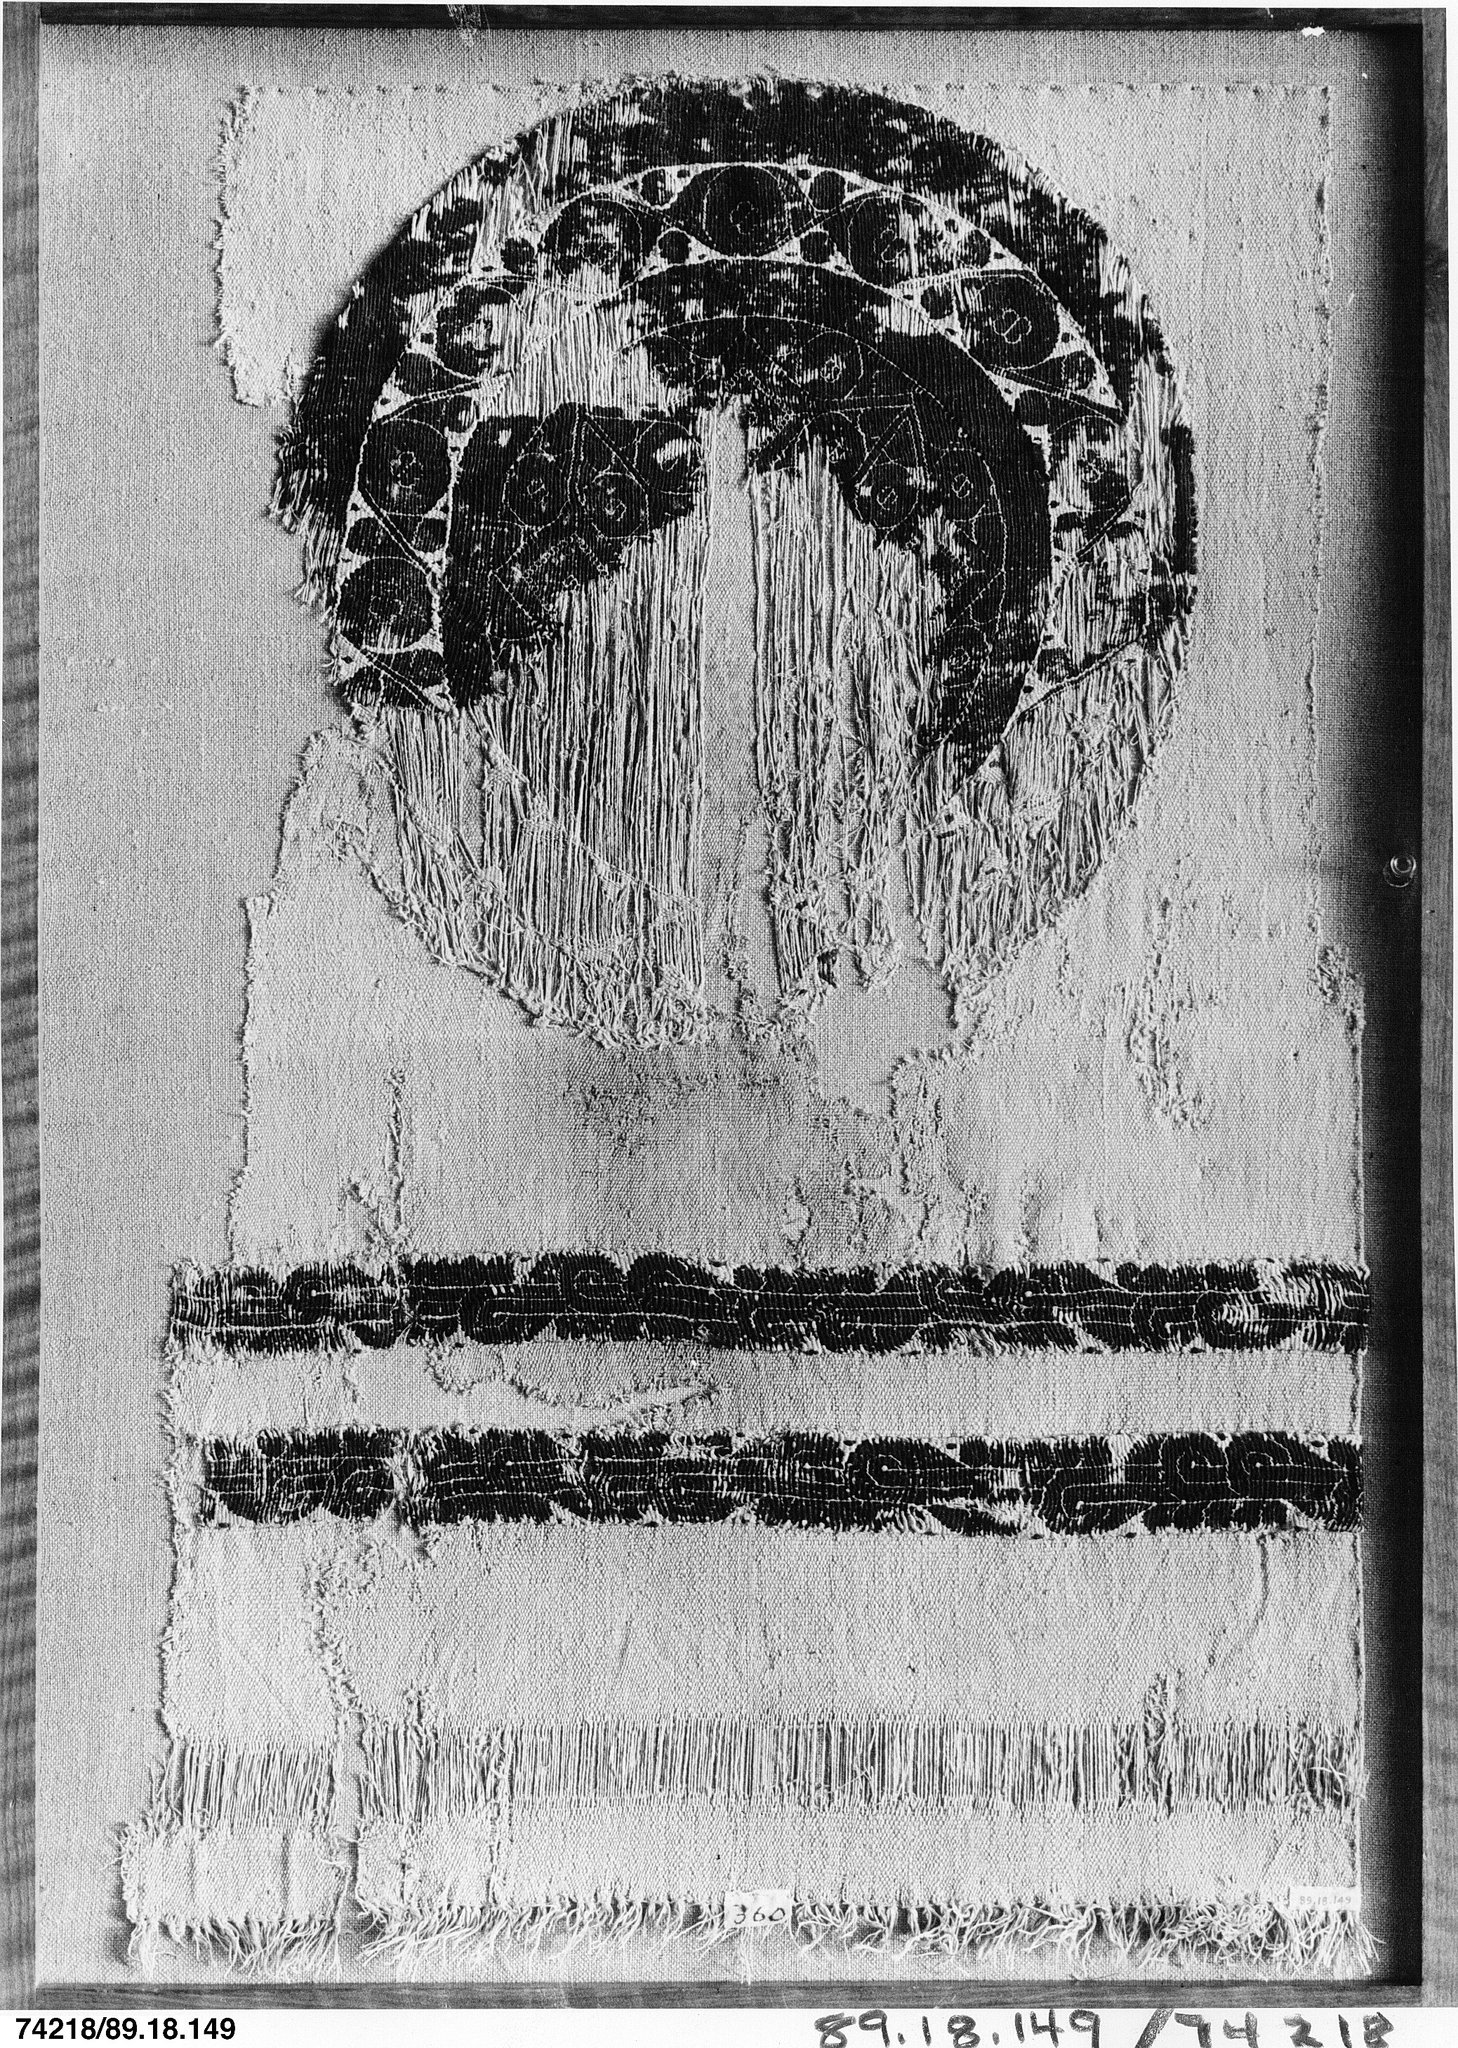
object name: textile fragment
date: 201-400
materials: linen, wool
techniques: weave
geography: egypt